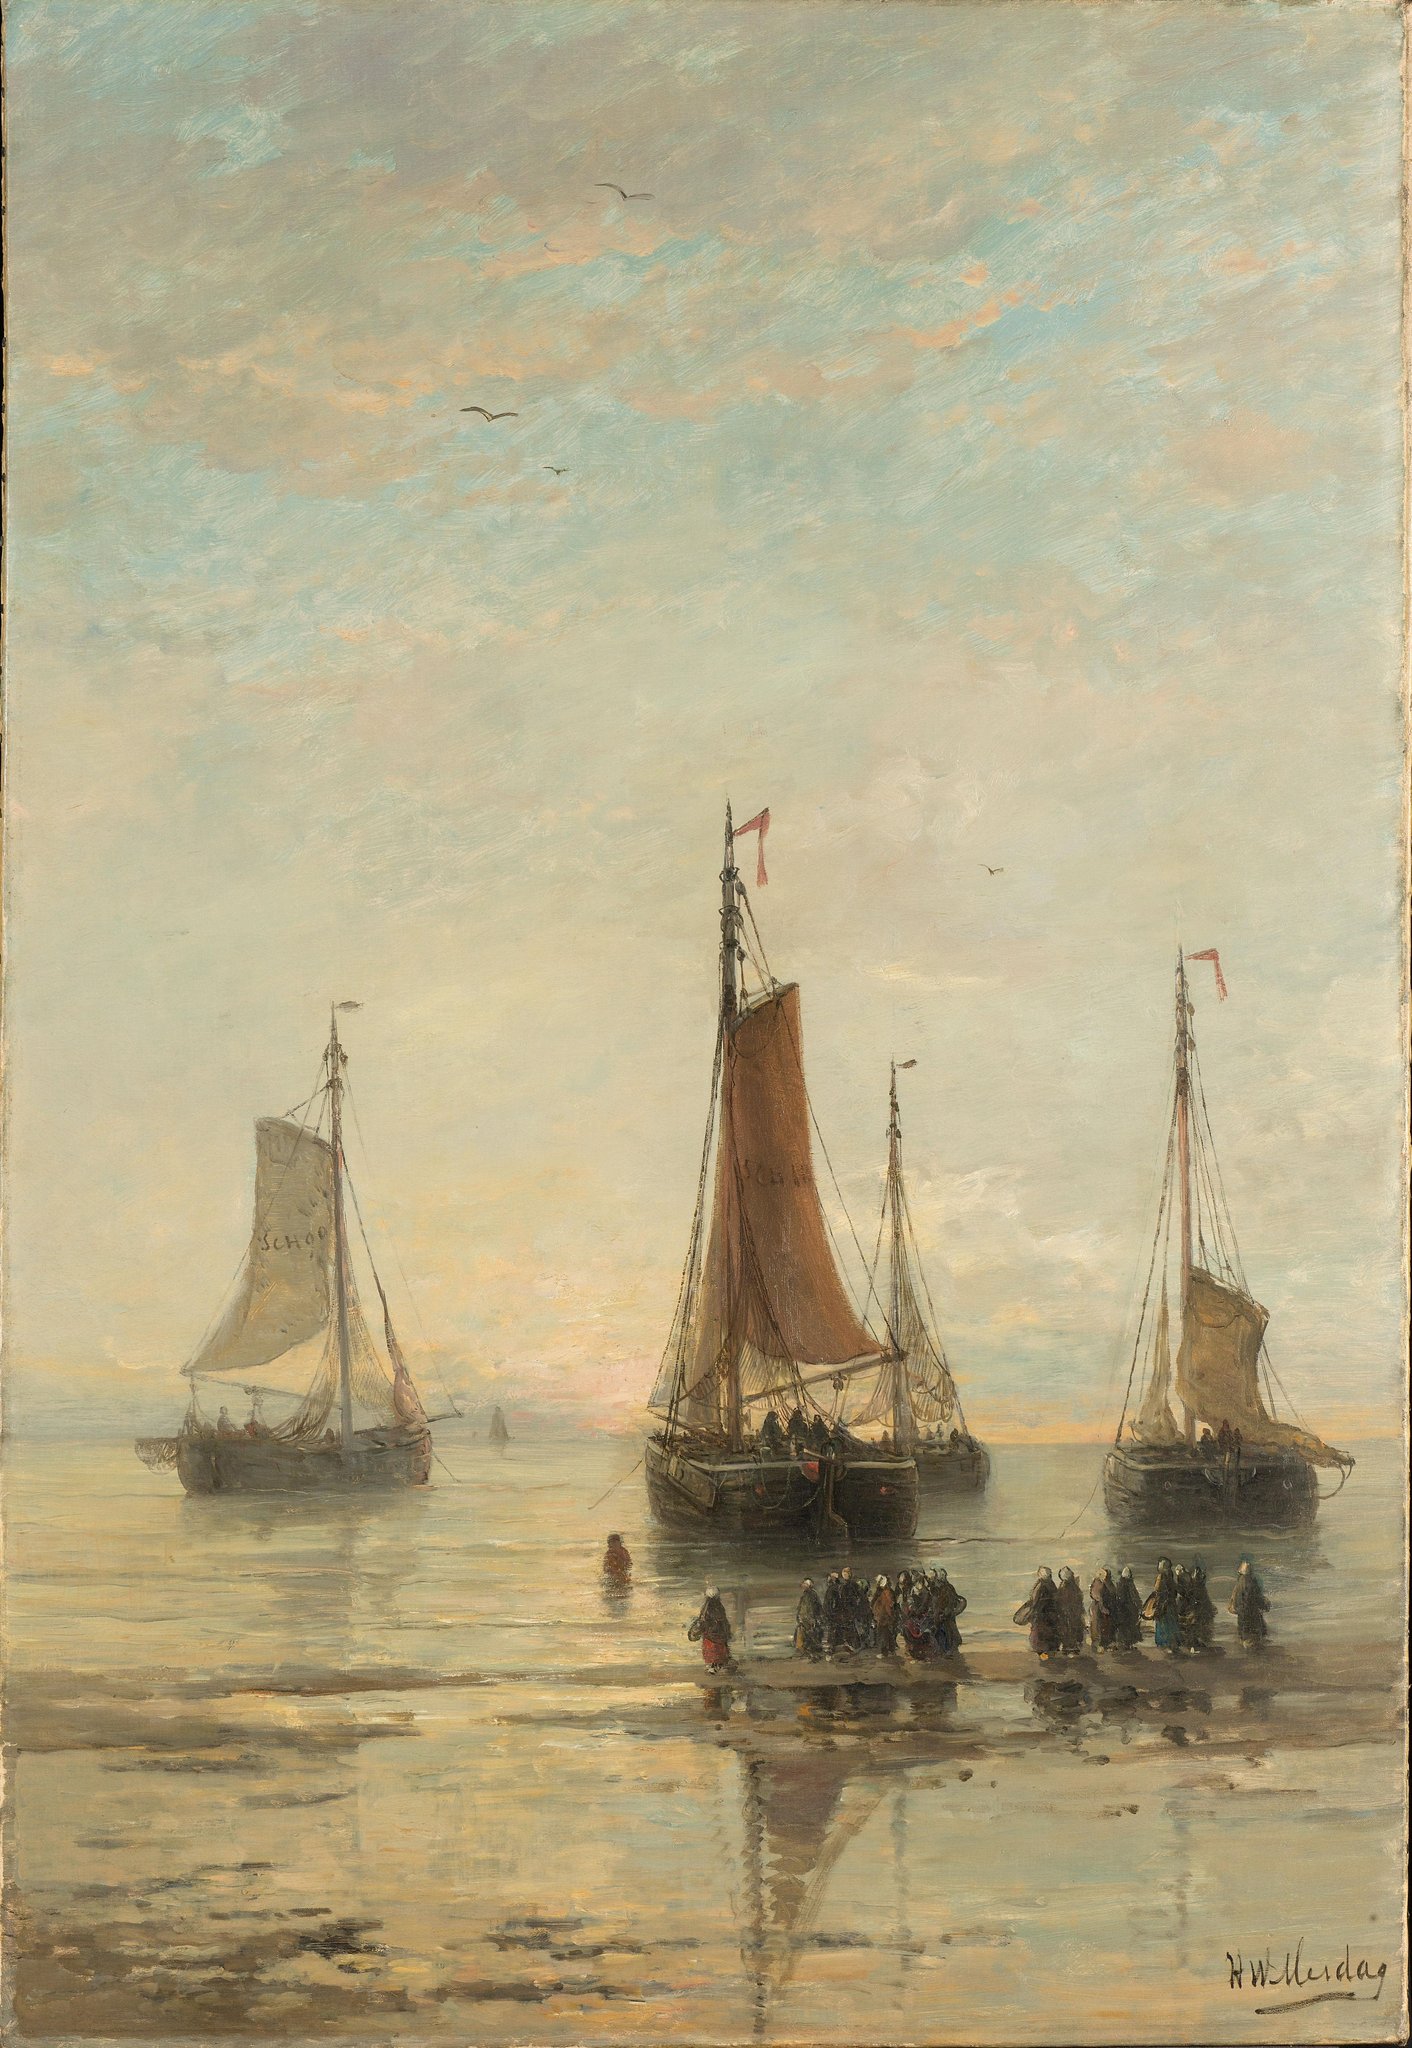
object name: painting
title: Bluff-Bowed Scheveningen Boats at Anchor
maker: hendrik willem mesdag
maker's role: draughtsman, painter, print maker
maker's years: 1831-1915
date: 1860-1889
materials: canvas, oil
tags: beach, sea and coastal fishery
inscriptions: signature: ‘HW Mesdag’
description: Scheveningse bommen voor anker. In het ondiepe water bij het strand liggen vier vissersschepen, bij de schepen staat een groep vissersvrouwen.